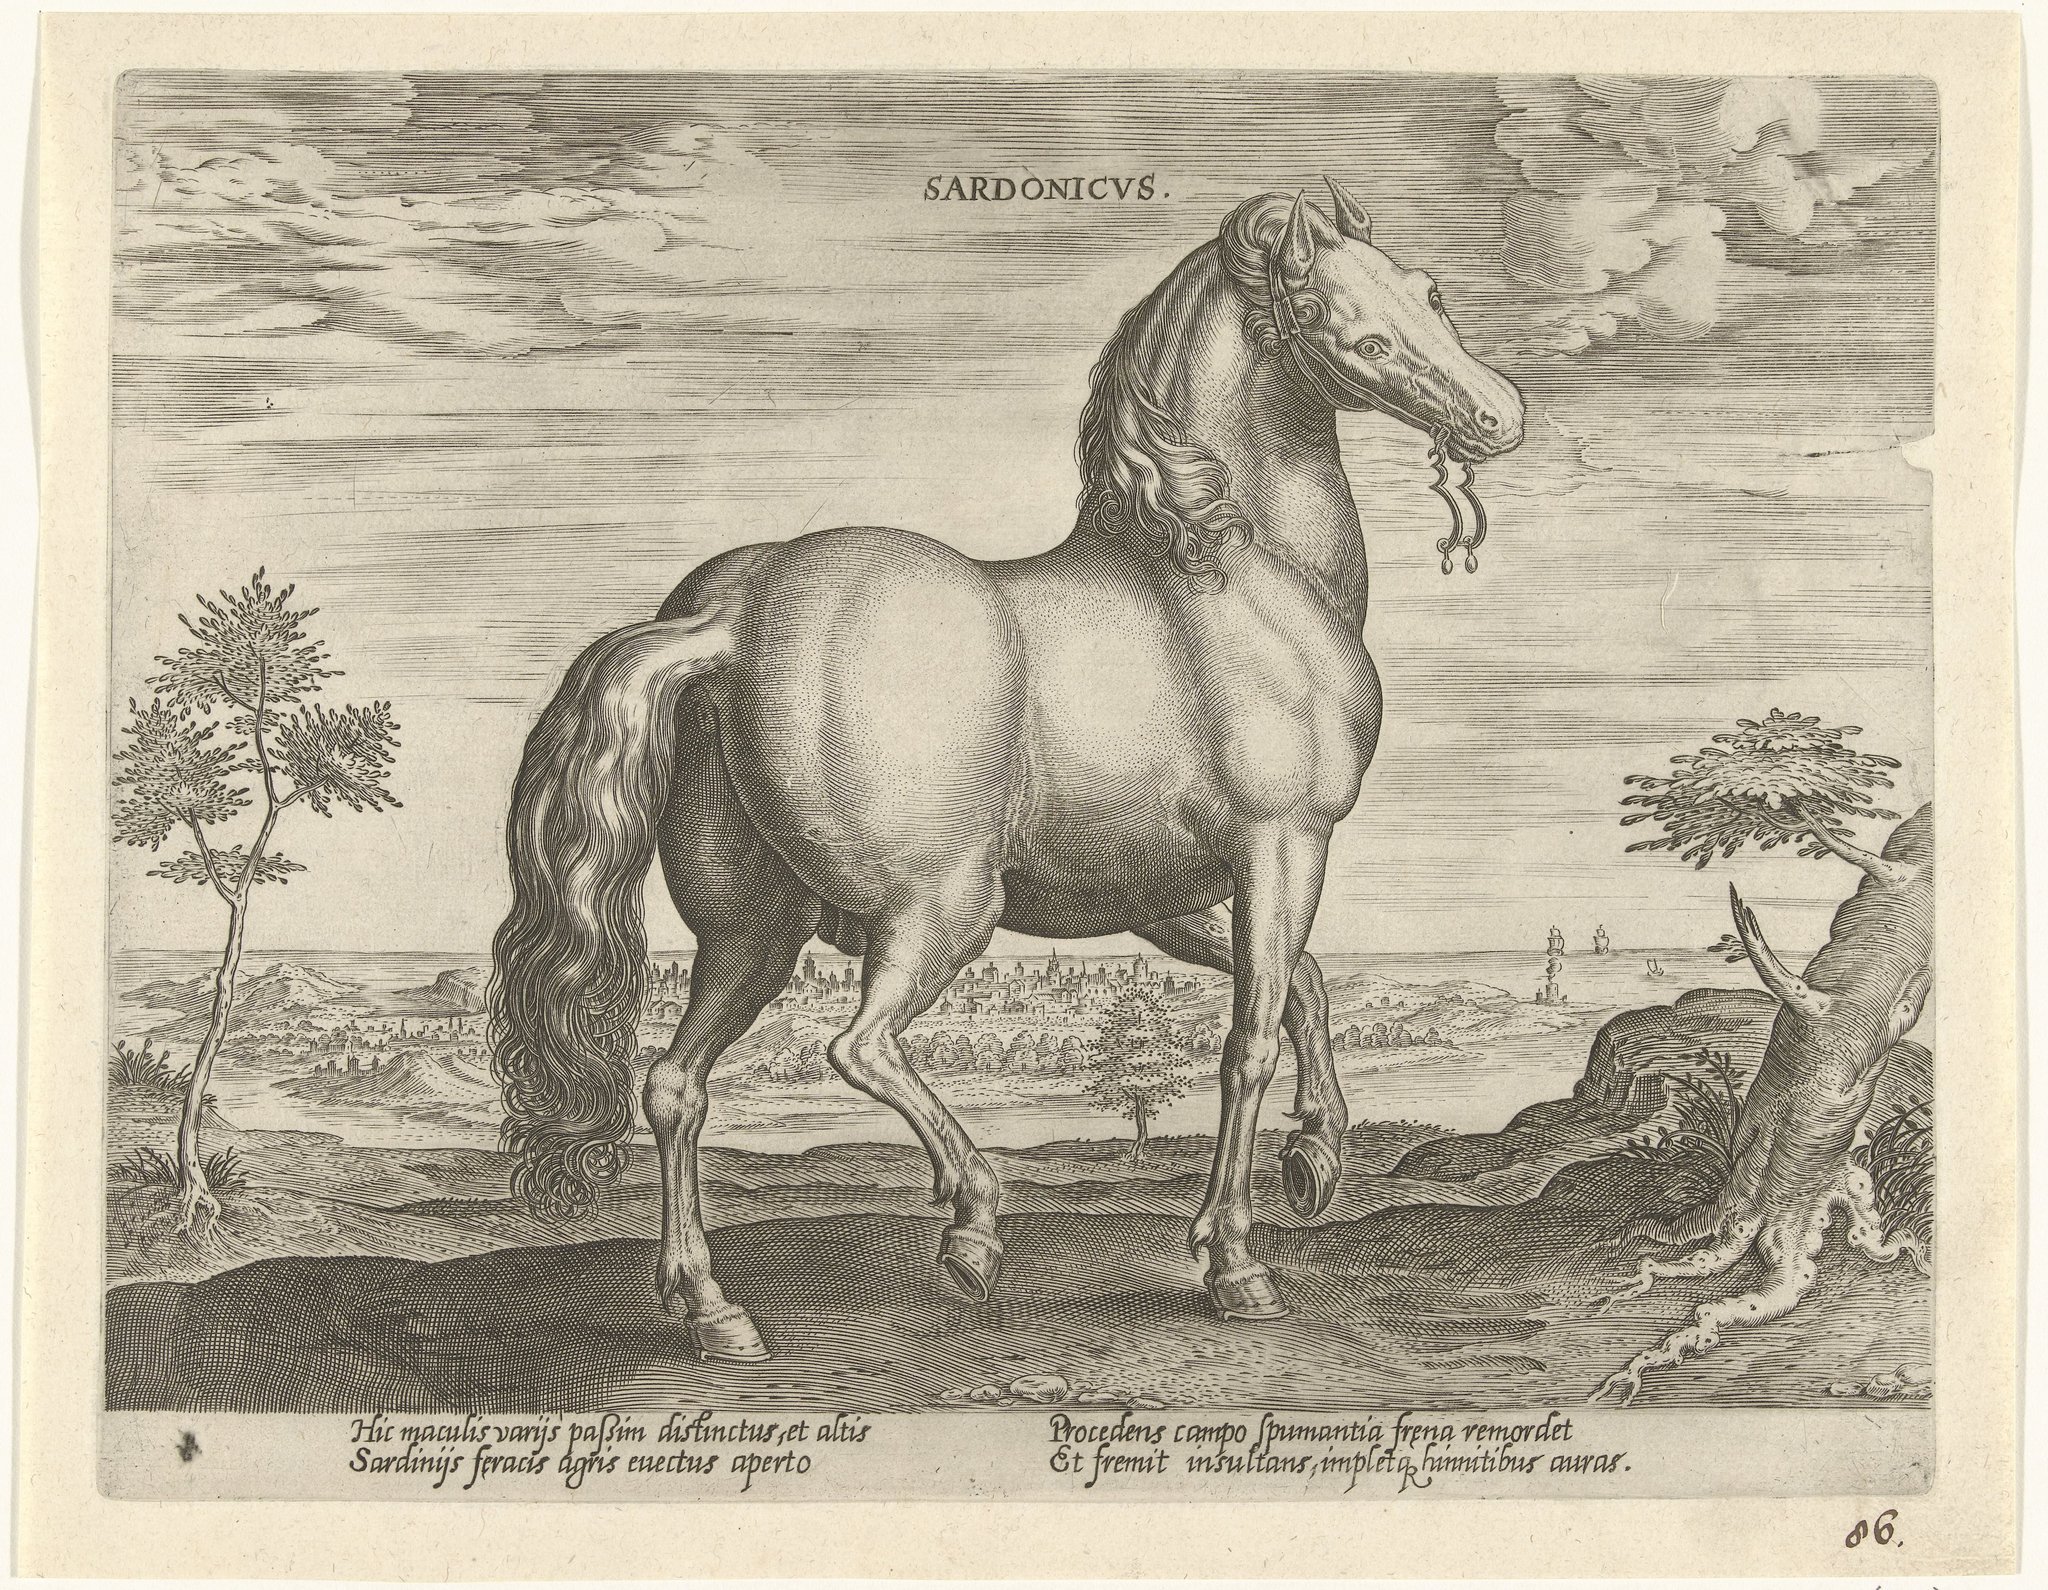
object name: print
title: Sardonicvs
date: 1578-1582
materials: paper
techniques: engraving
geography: antwerp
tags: don juan van oostenrijk, horses and kindred animals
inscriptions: collector's mark: Lugt 2228, number: ‘86’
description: Een Sardinisch paard, van achteren. De prent heeft een Latijns onderschrift en maakt deel uit van het derde deel van een 39-delige serie over de paardenrassen uit Koninklijke stallen van Don Juan van Oostenrijk.